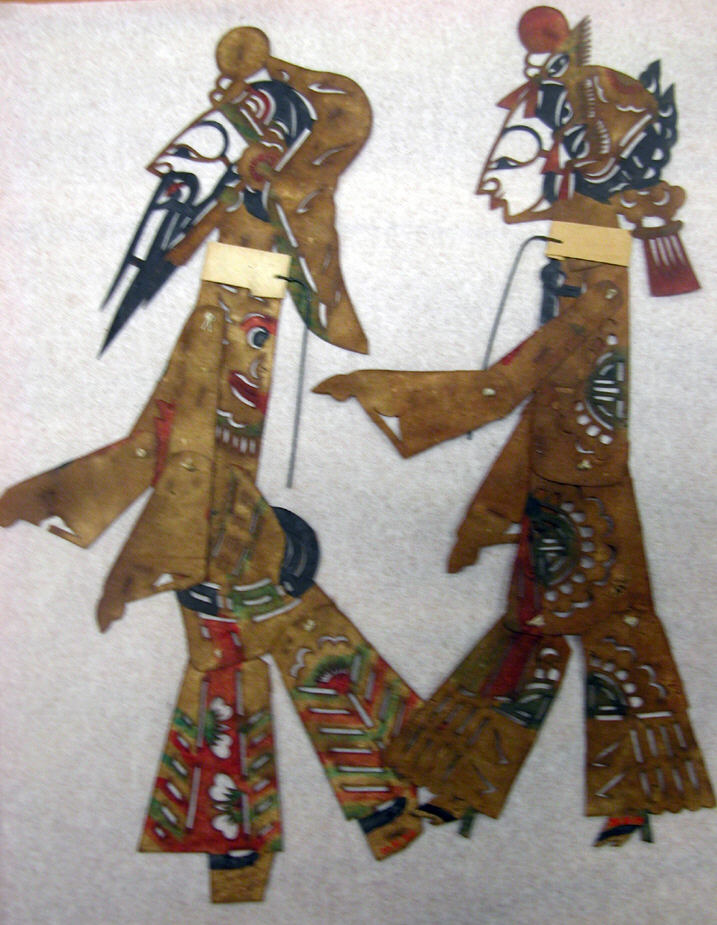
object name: shadow player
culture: chinese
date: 1801-1900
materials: cord, skin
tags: men,women